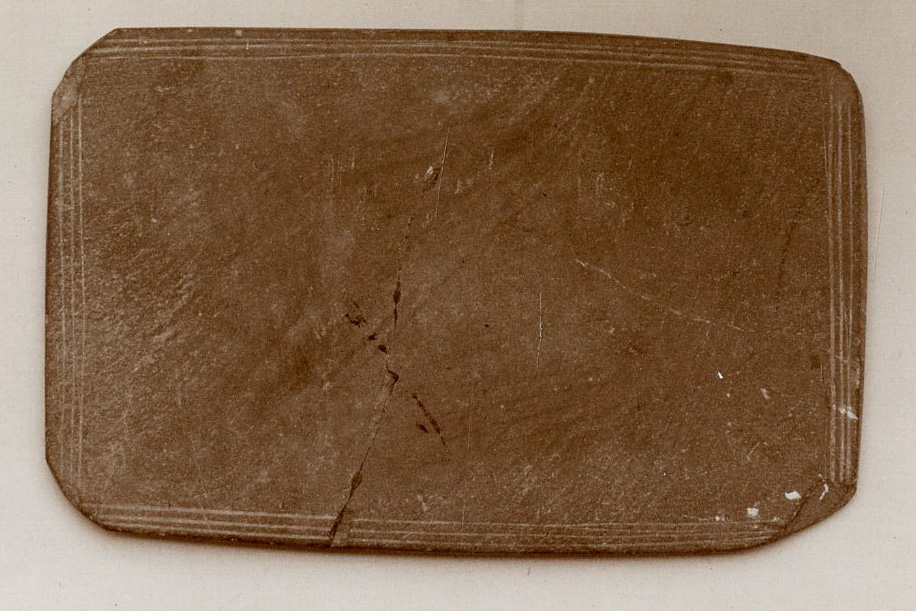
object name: palette, rectangular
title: Palette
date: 3850-2960 BCE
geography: egypt